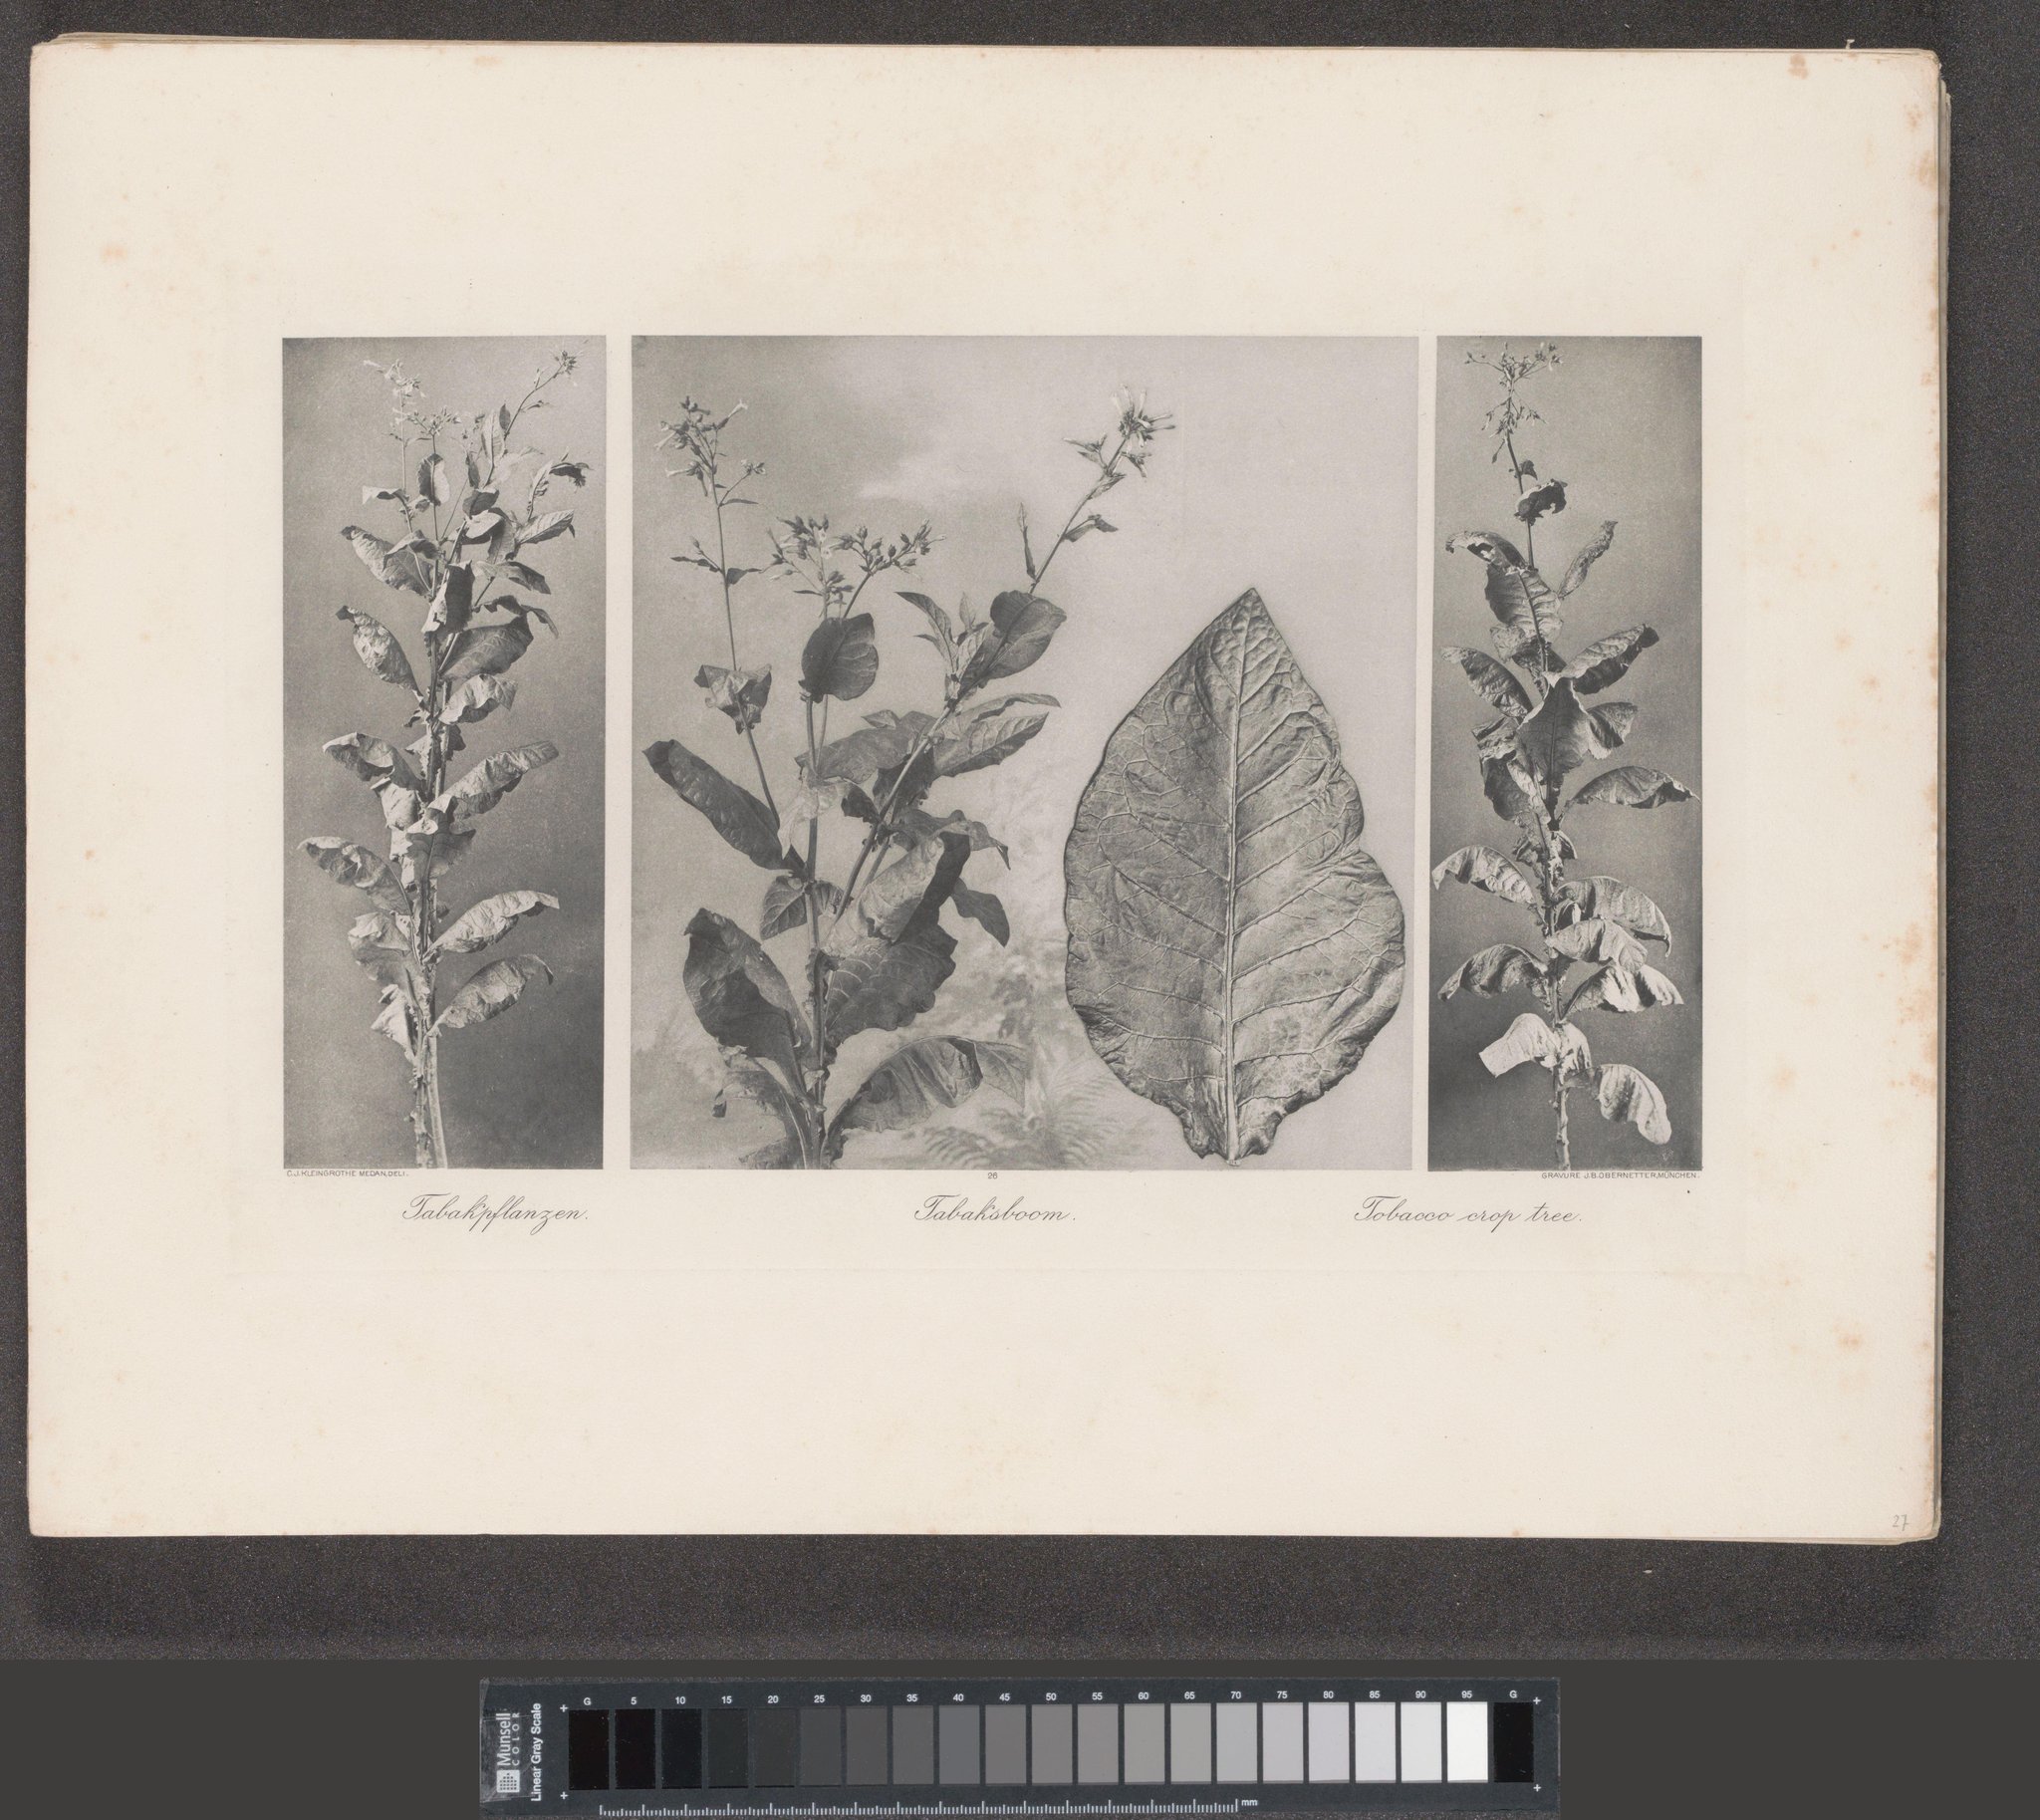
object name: photomechanical print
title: Tabaksboom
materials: paper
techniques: photoaquatint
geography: munich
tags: tobacco, sumatra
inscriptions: number: ‘26’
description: Onderdeel van Album met heliogravures van Sumatra's oostkust.